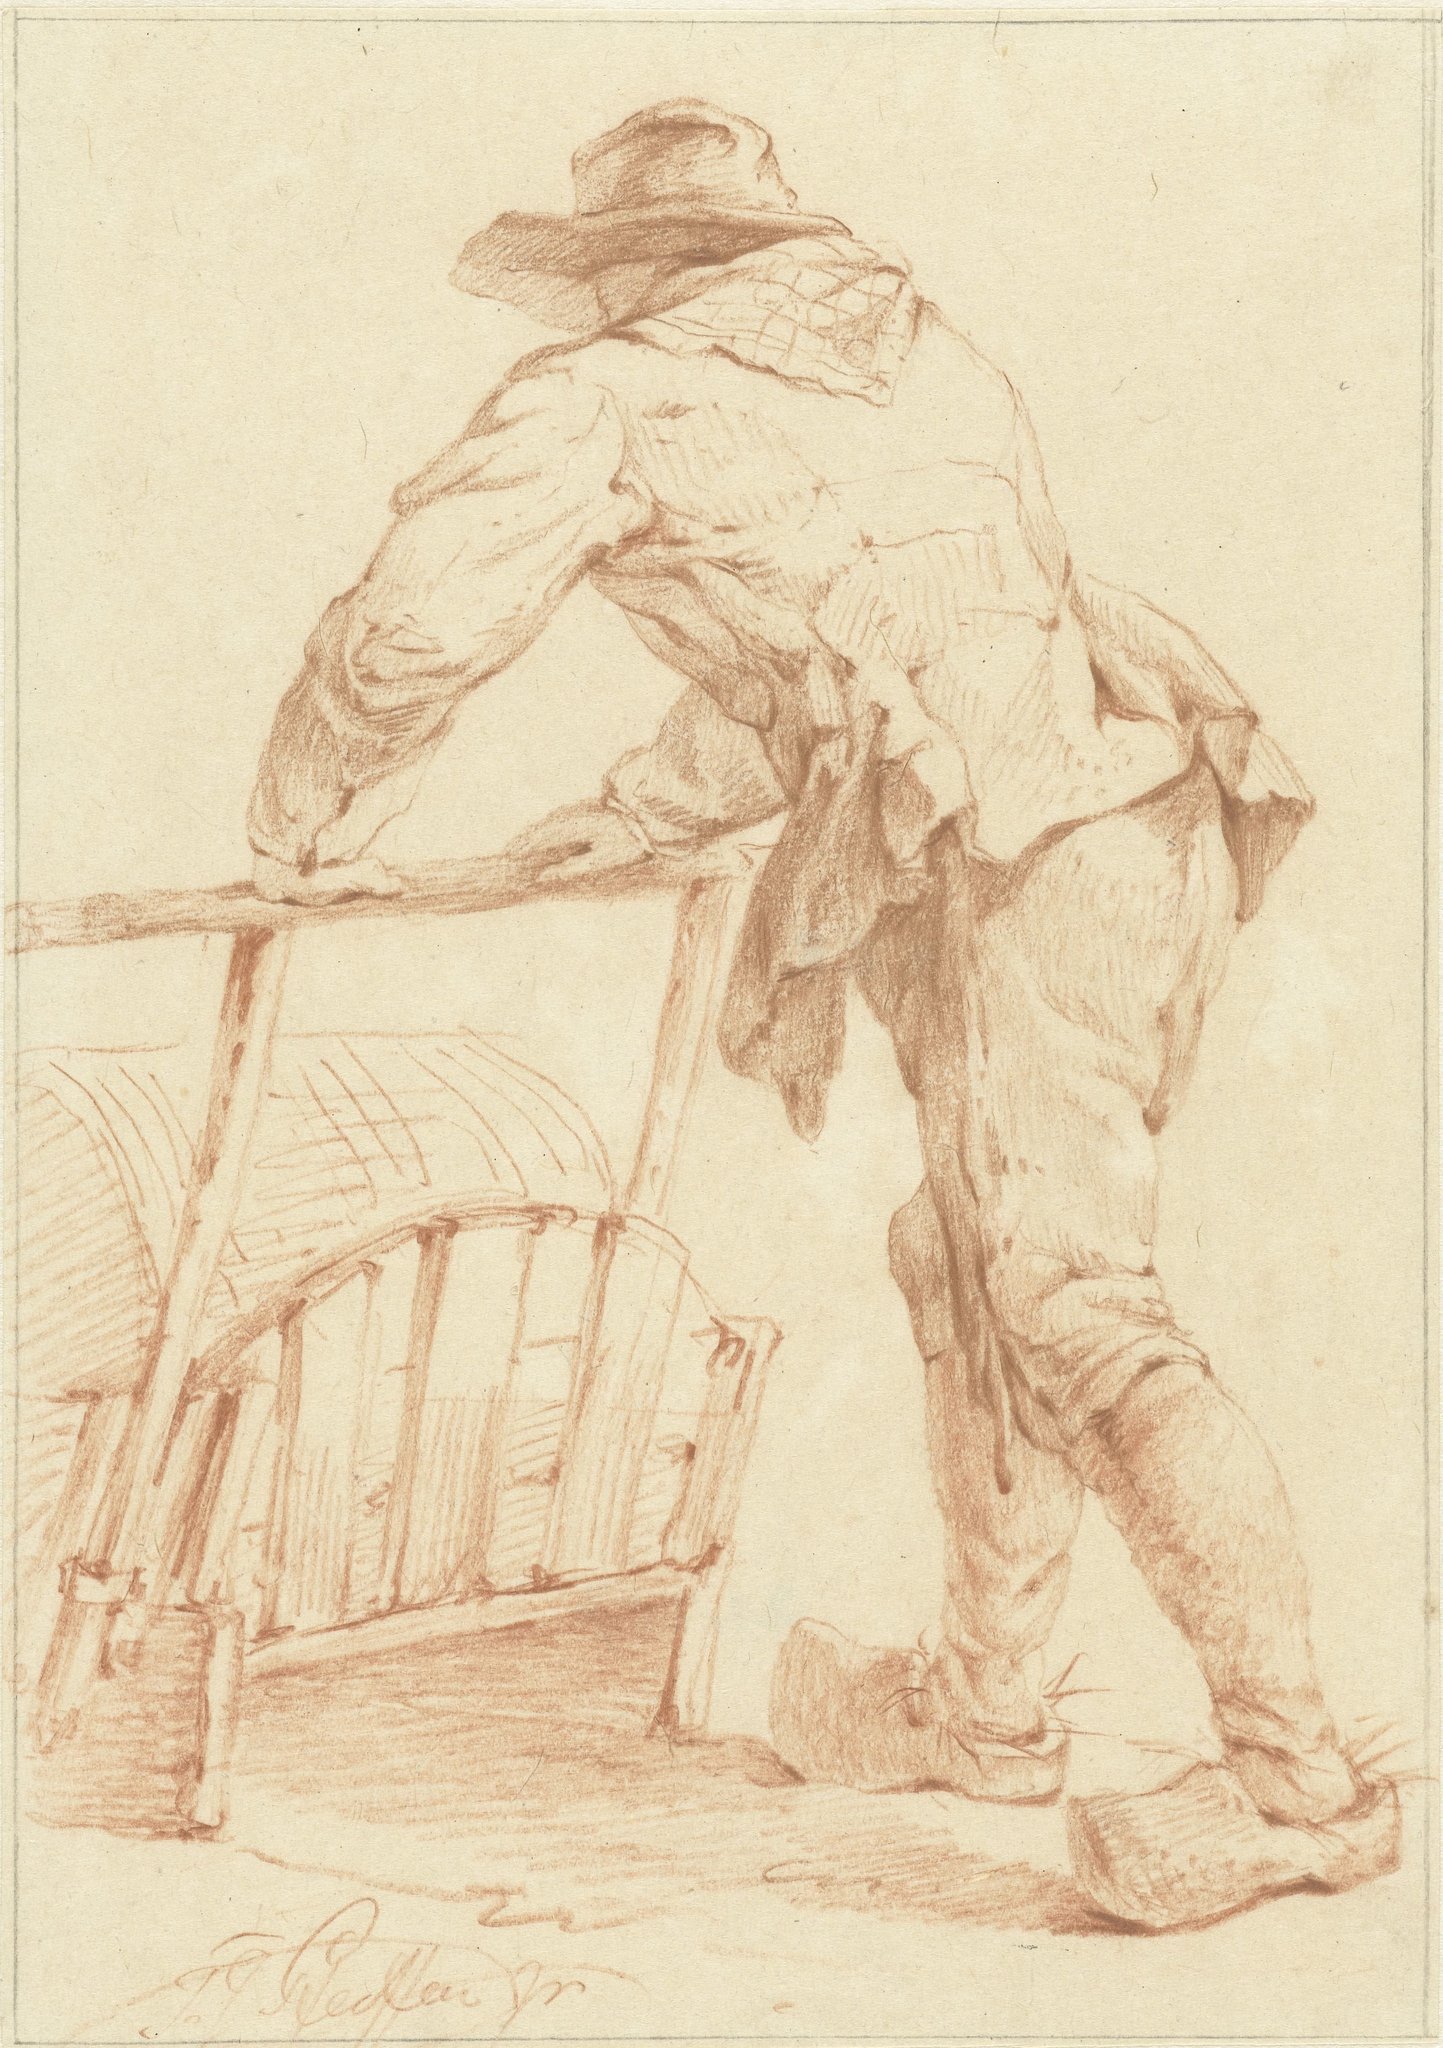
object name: drawing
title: Jongen op klompen, duwend tegen een slee (?)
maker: françois joseph pfeiffer (ii)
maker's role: draughtsman, print maker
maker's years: 1778-1835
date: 1788-1835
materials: chalk, paper